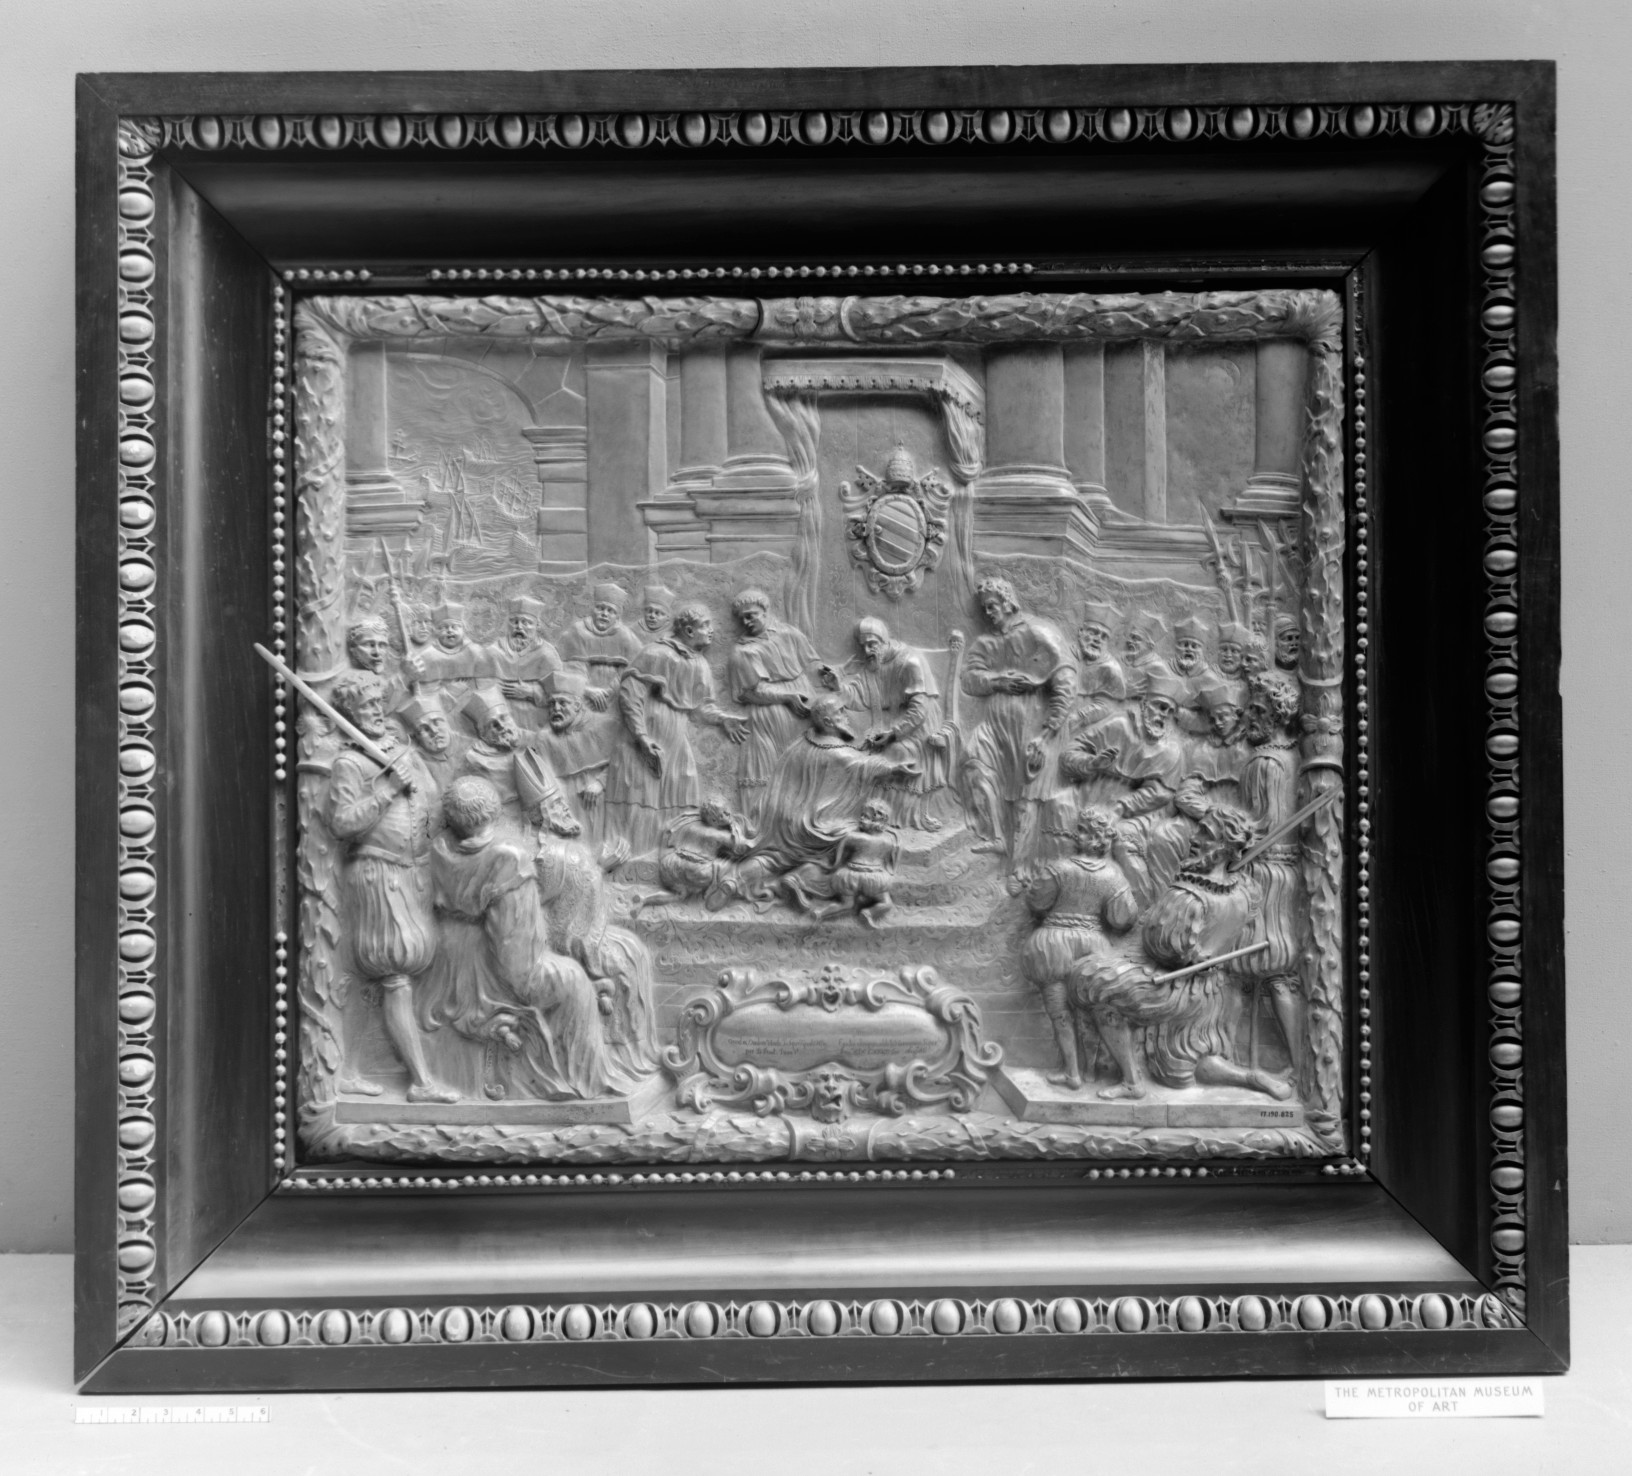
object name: plaque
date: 1677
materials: copper gilt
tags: swords,men